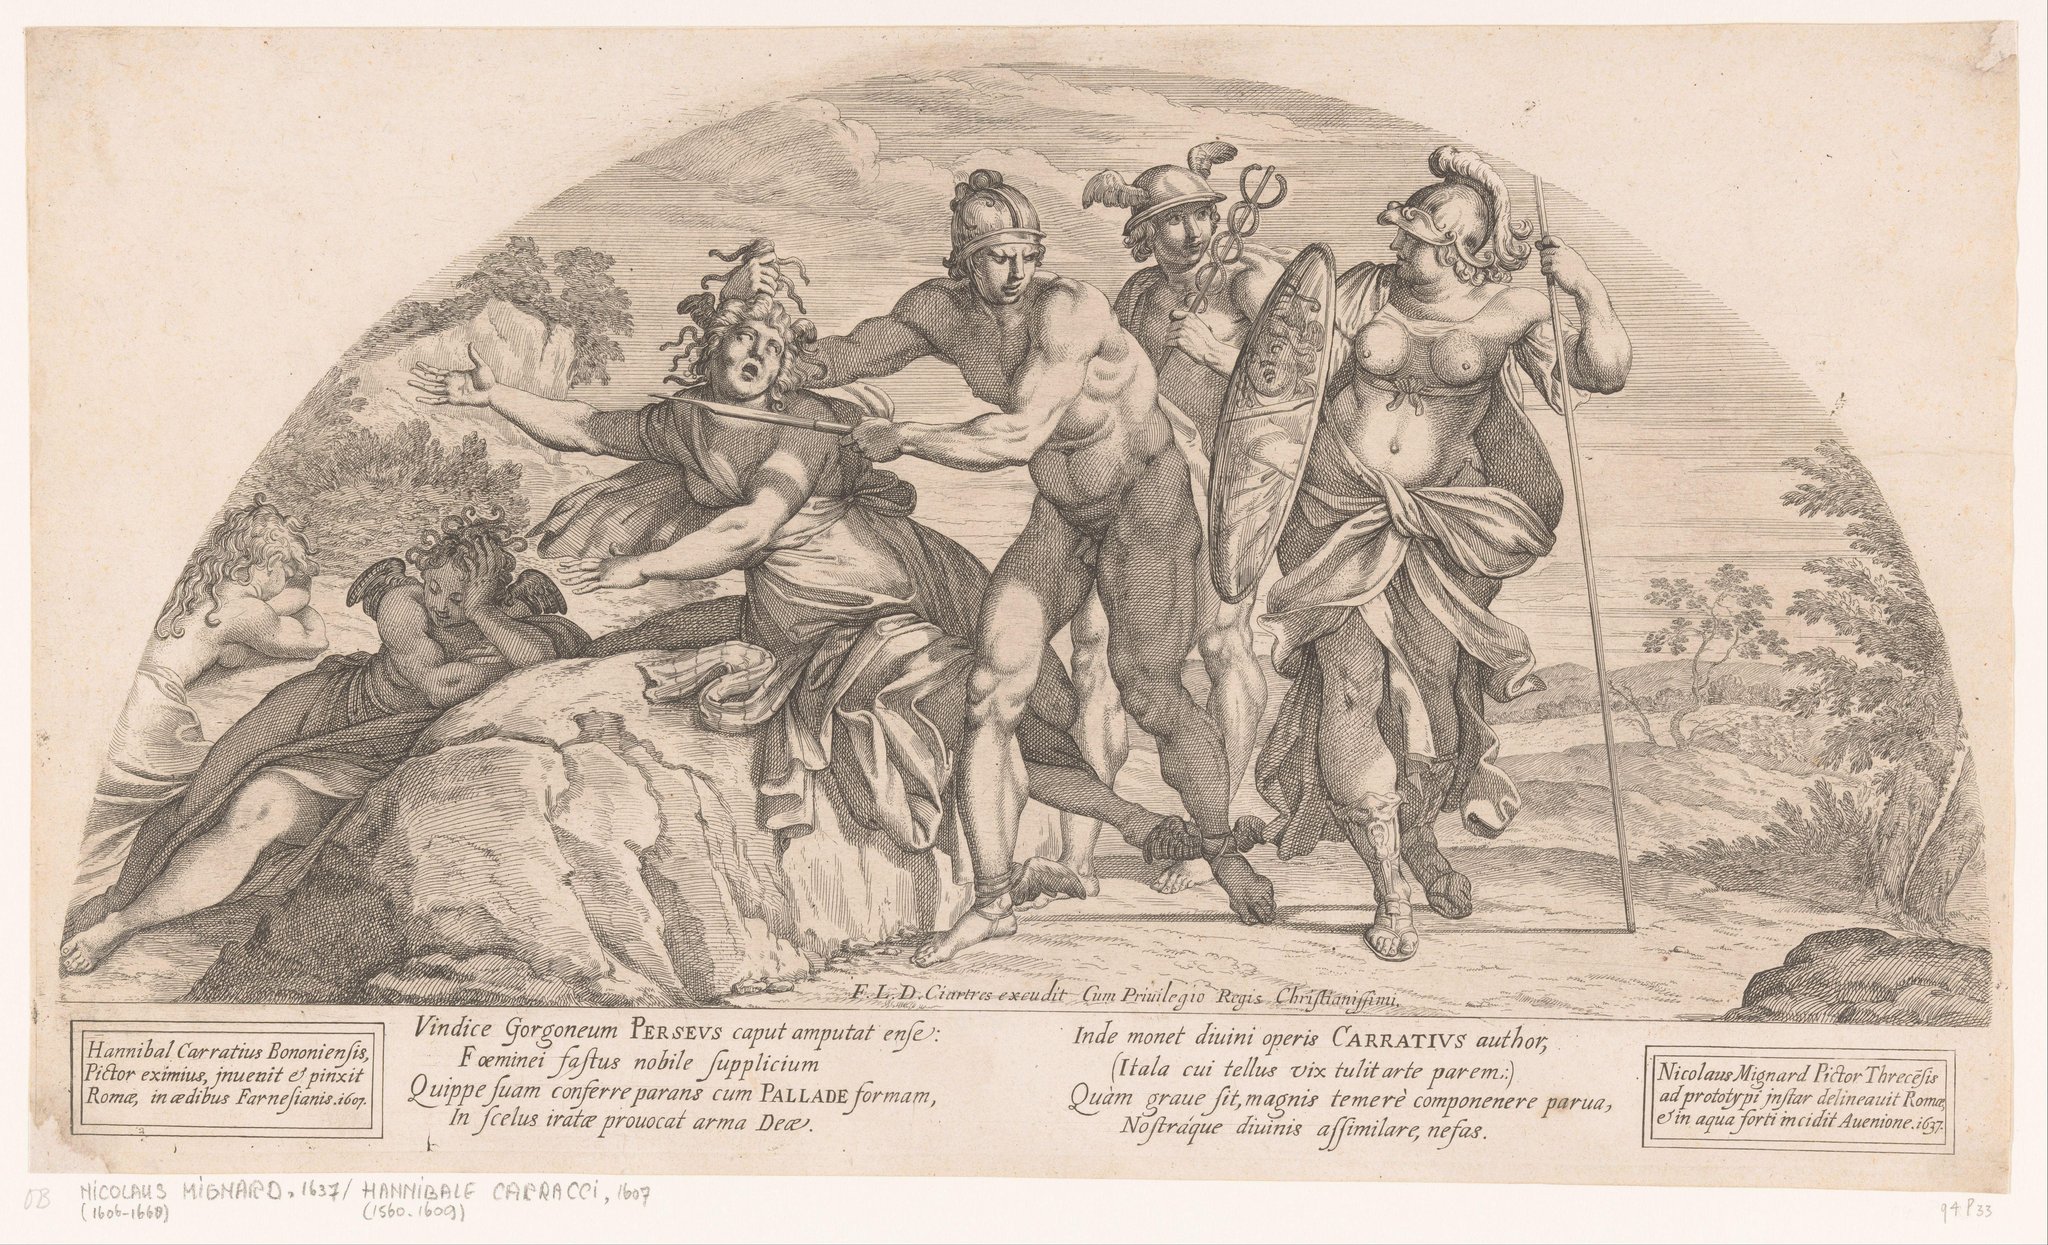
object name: print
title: Perseus onthoofdt Medusa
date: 1637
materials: paper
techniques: engraving, etching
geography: rome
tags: perseus beheading medusa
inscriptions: collector's mark: Lugt 2228